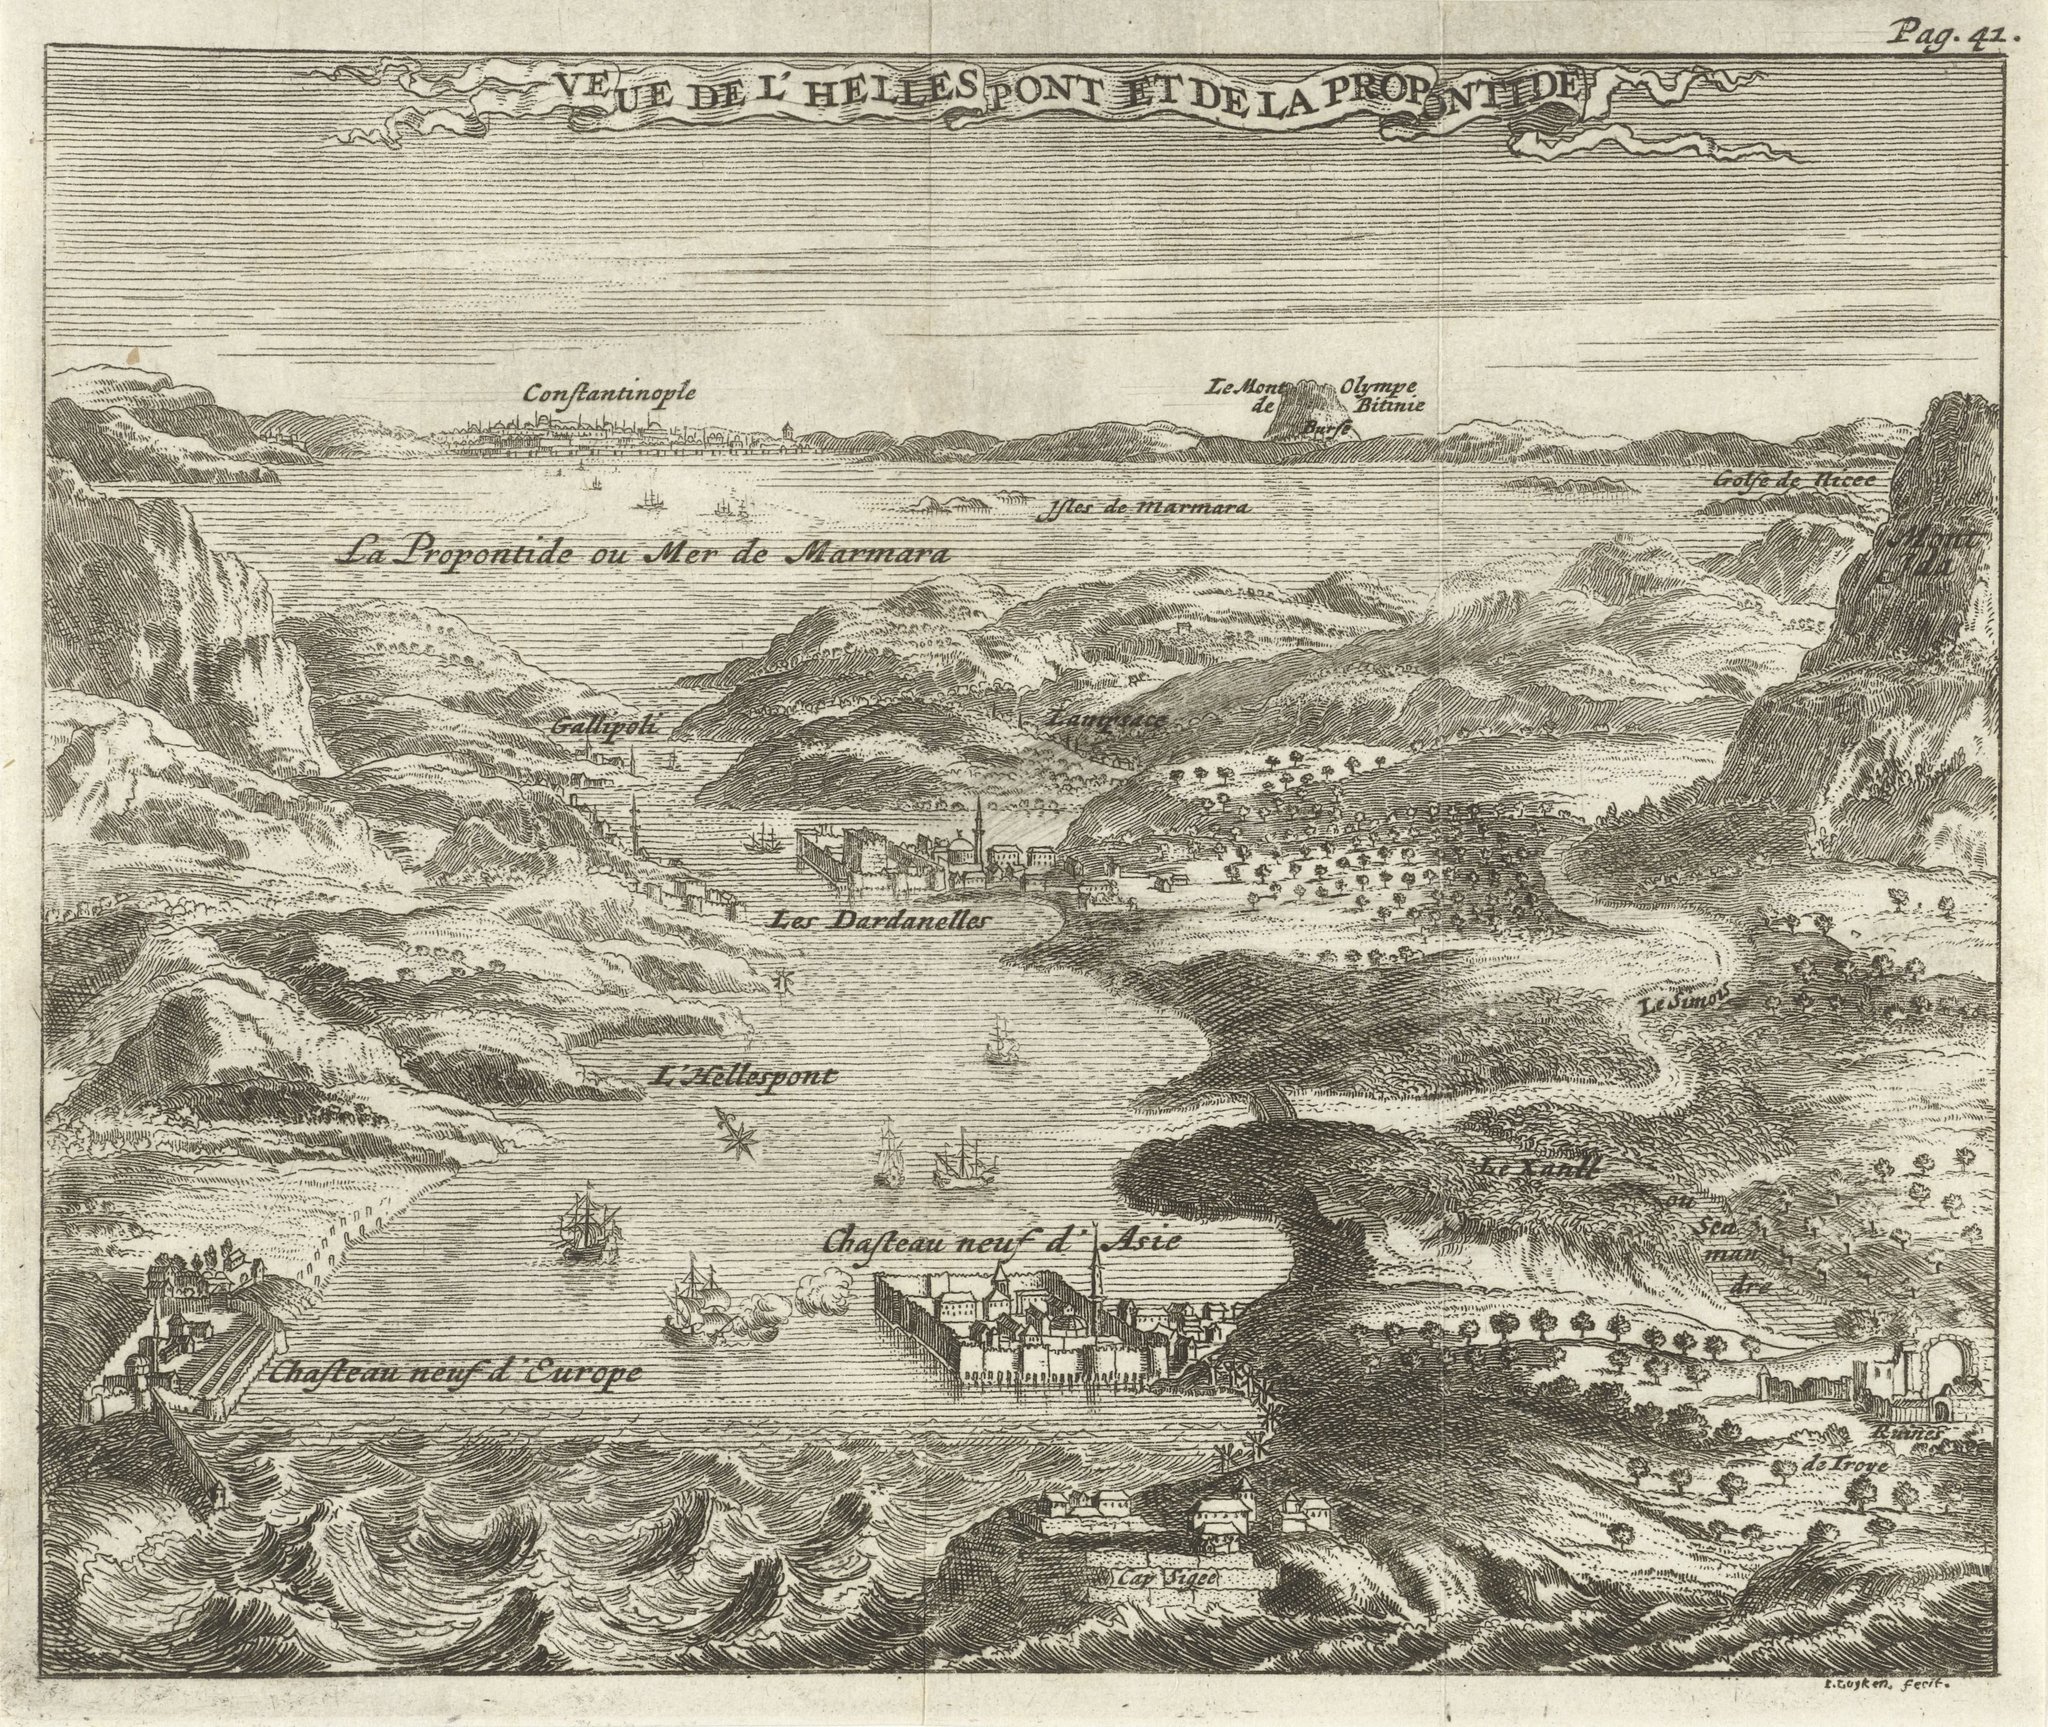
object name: book illustration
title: Veue de l'Hellespont et de la Propontide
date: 1681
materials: paper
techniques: etching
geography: paris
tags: straits, narrows, ships (in general)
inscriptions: collector's mark: Lugt 2228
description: Illustratie opgenomen in: Grélot, Guillaume Joseph. Relation nouvelle d'un voyage de Constantinople. Parijs: Pierre Rocolet en wed. Damien Foucault, 1681.